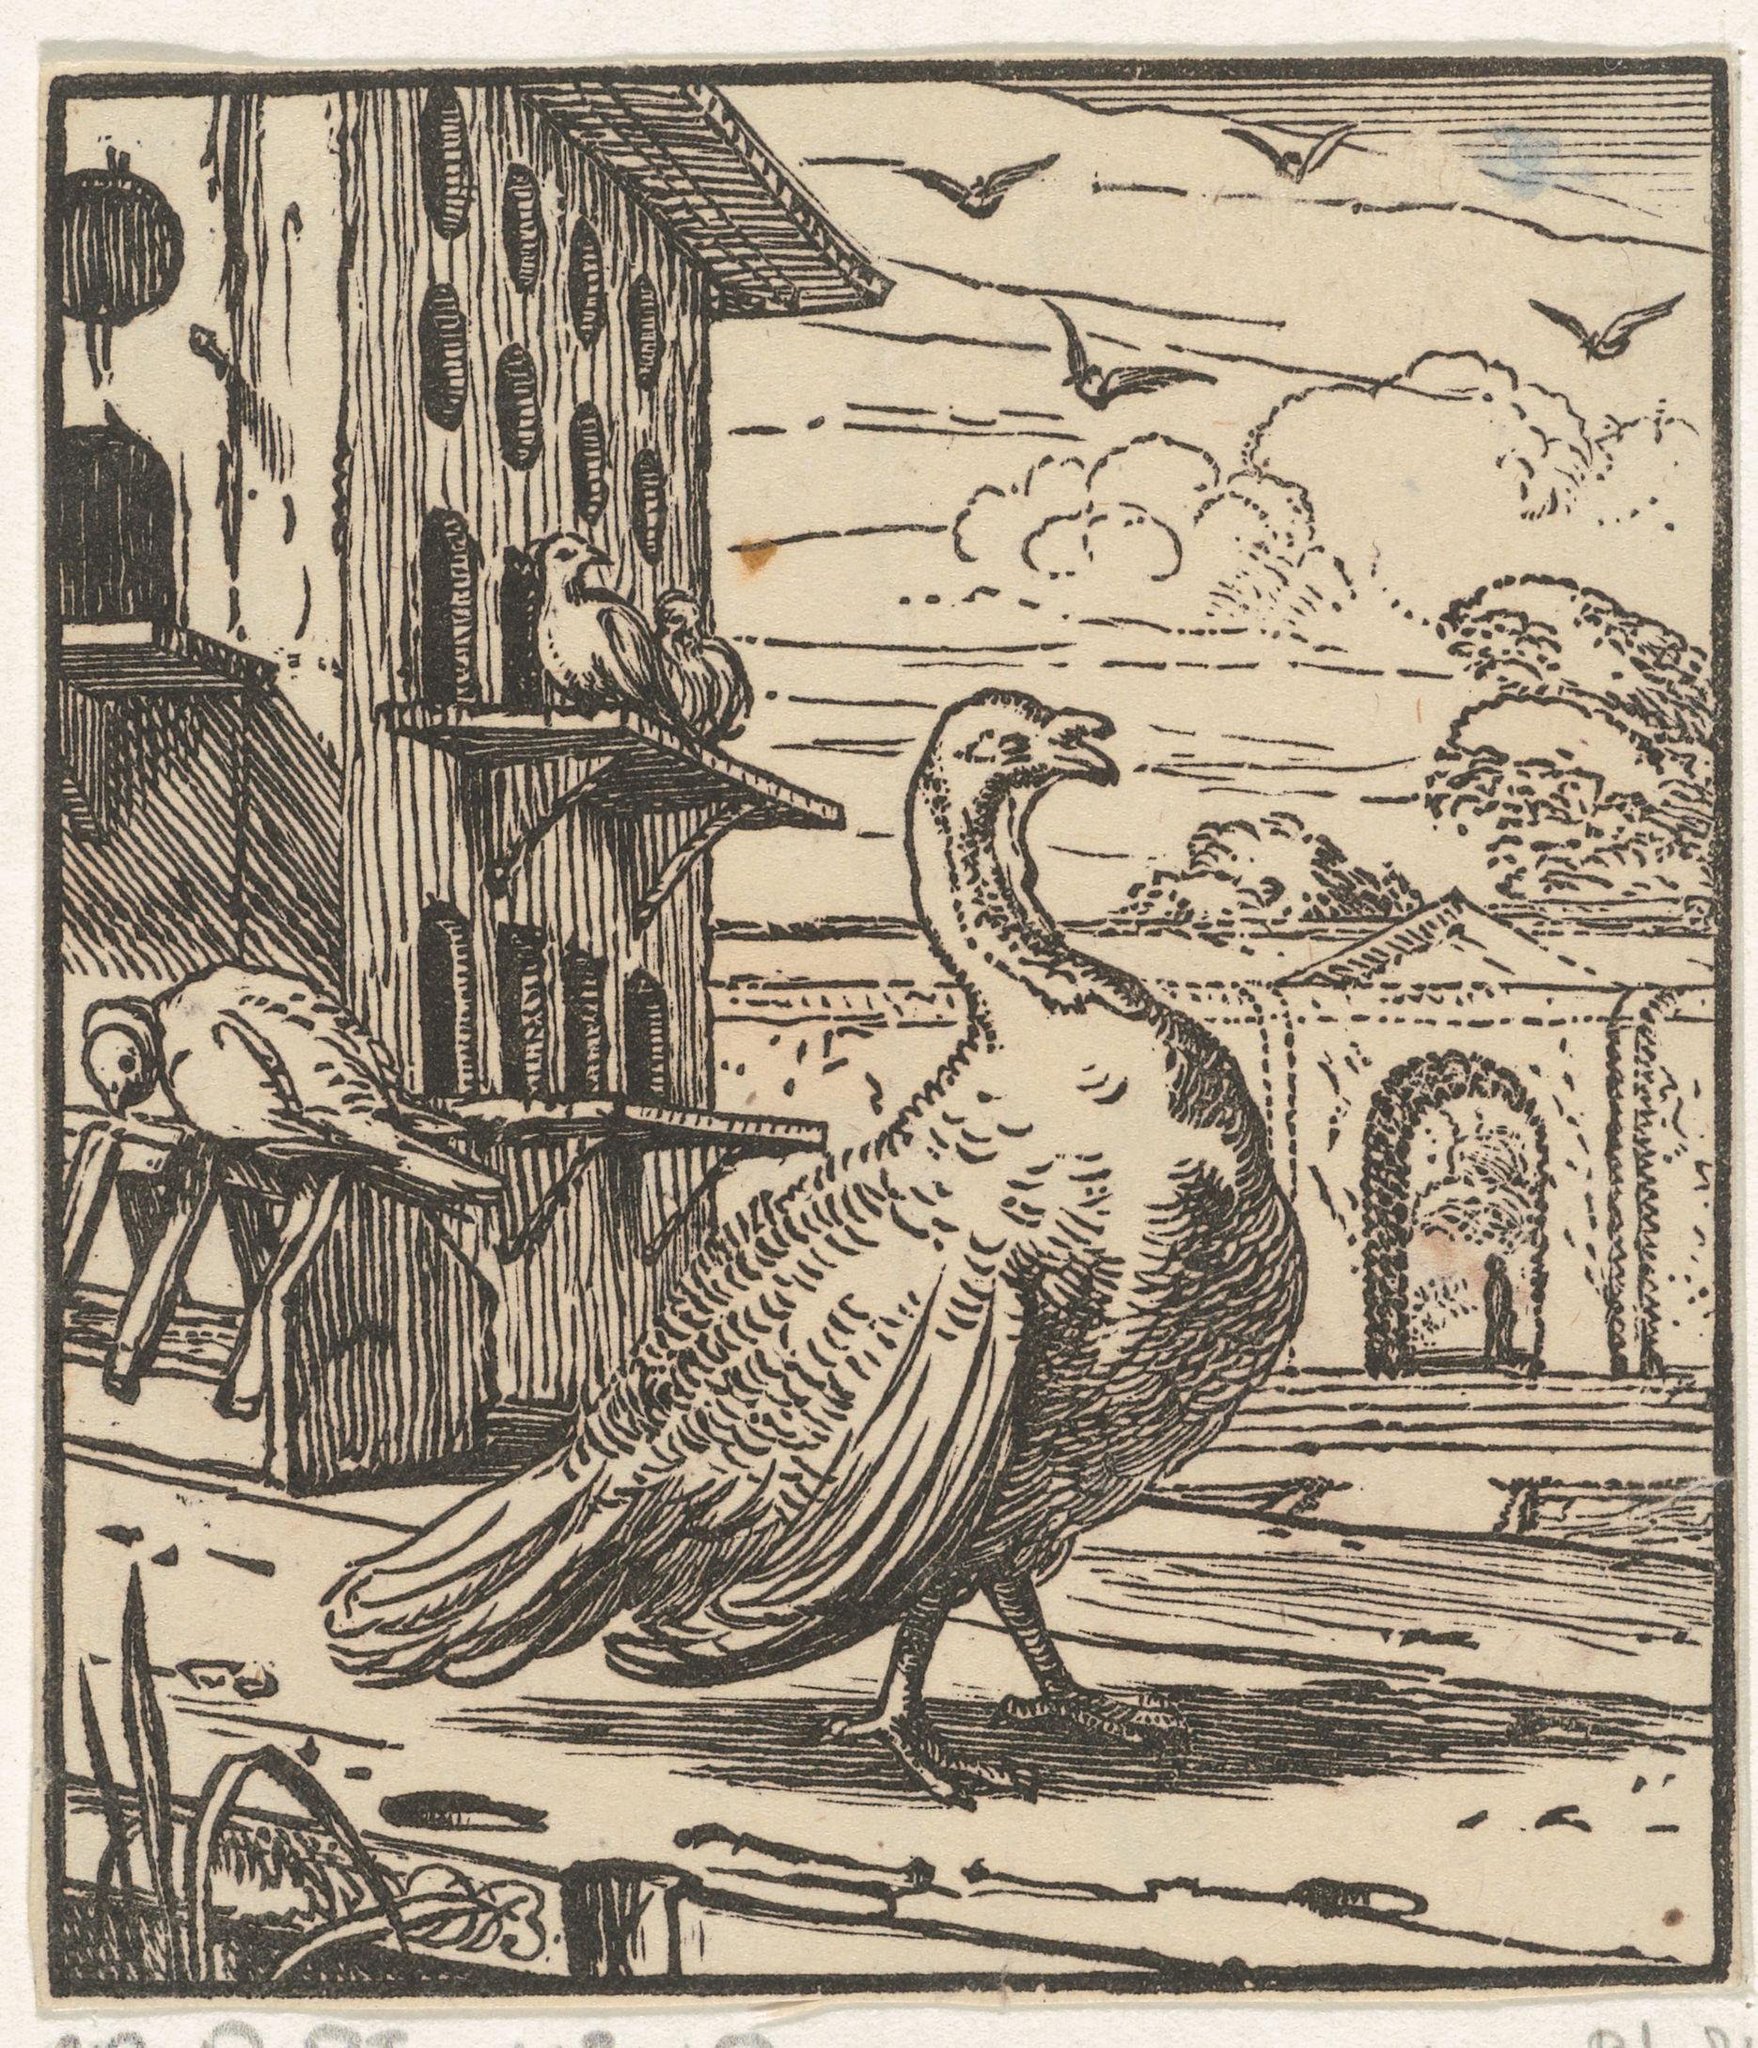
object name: print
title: Kalkoen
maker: dirck de bray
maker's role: draughtsman, painter, print maker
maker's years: 1625-1694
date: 1660-1662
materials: paper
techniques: woodcut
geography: netherlands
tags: walker and runner birds: turkey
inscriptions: collector's mark: Lugt 240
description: De vogel is gedetermineerd als zijnde een kalkoen, maar in de literatuur over De Bray wordt gesproken over een 'grote mannetjesduif'.